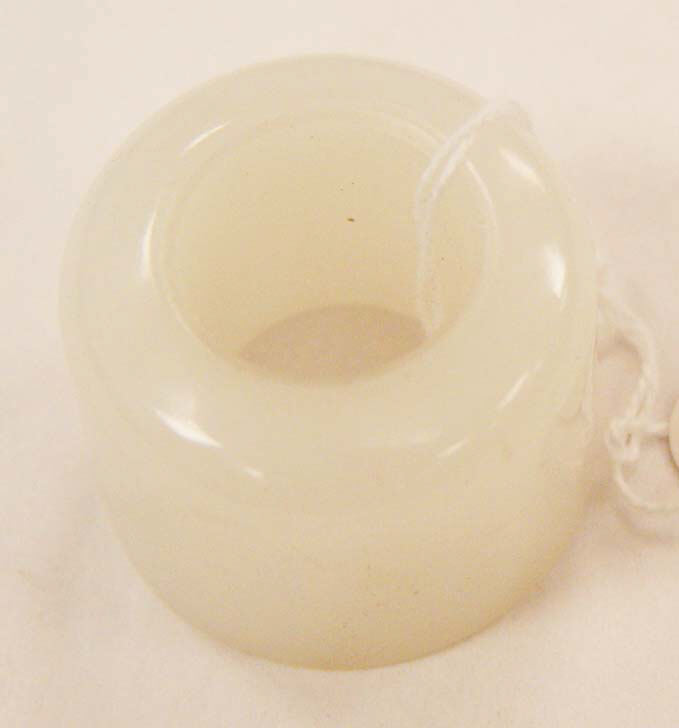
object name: ring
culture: chinese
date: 1801-1900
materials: jade